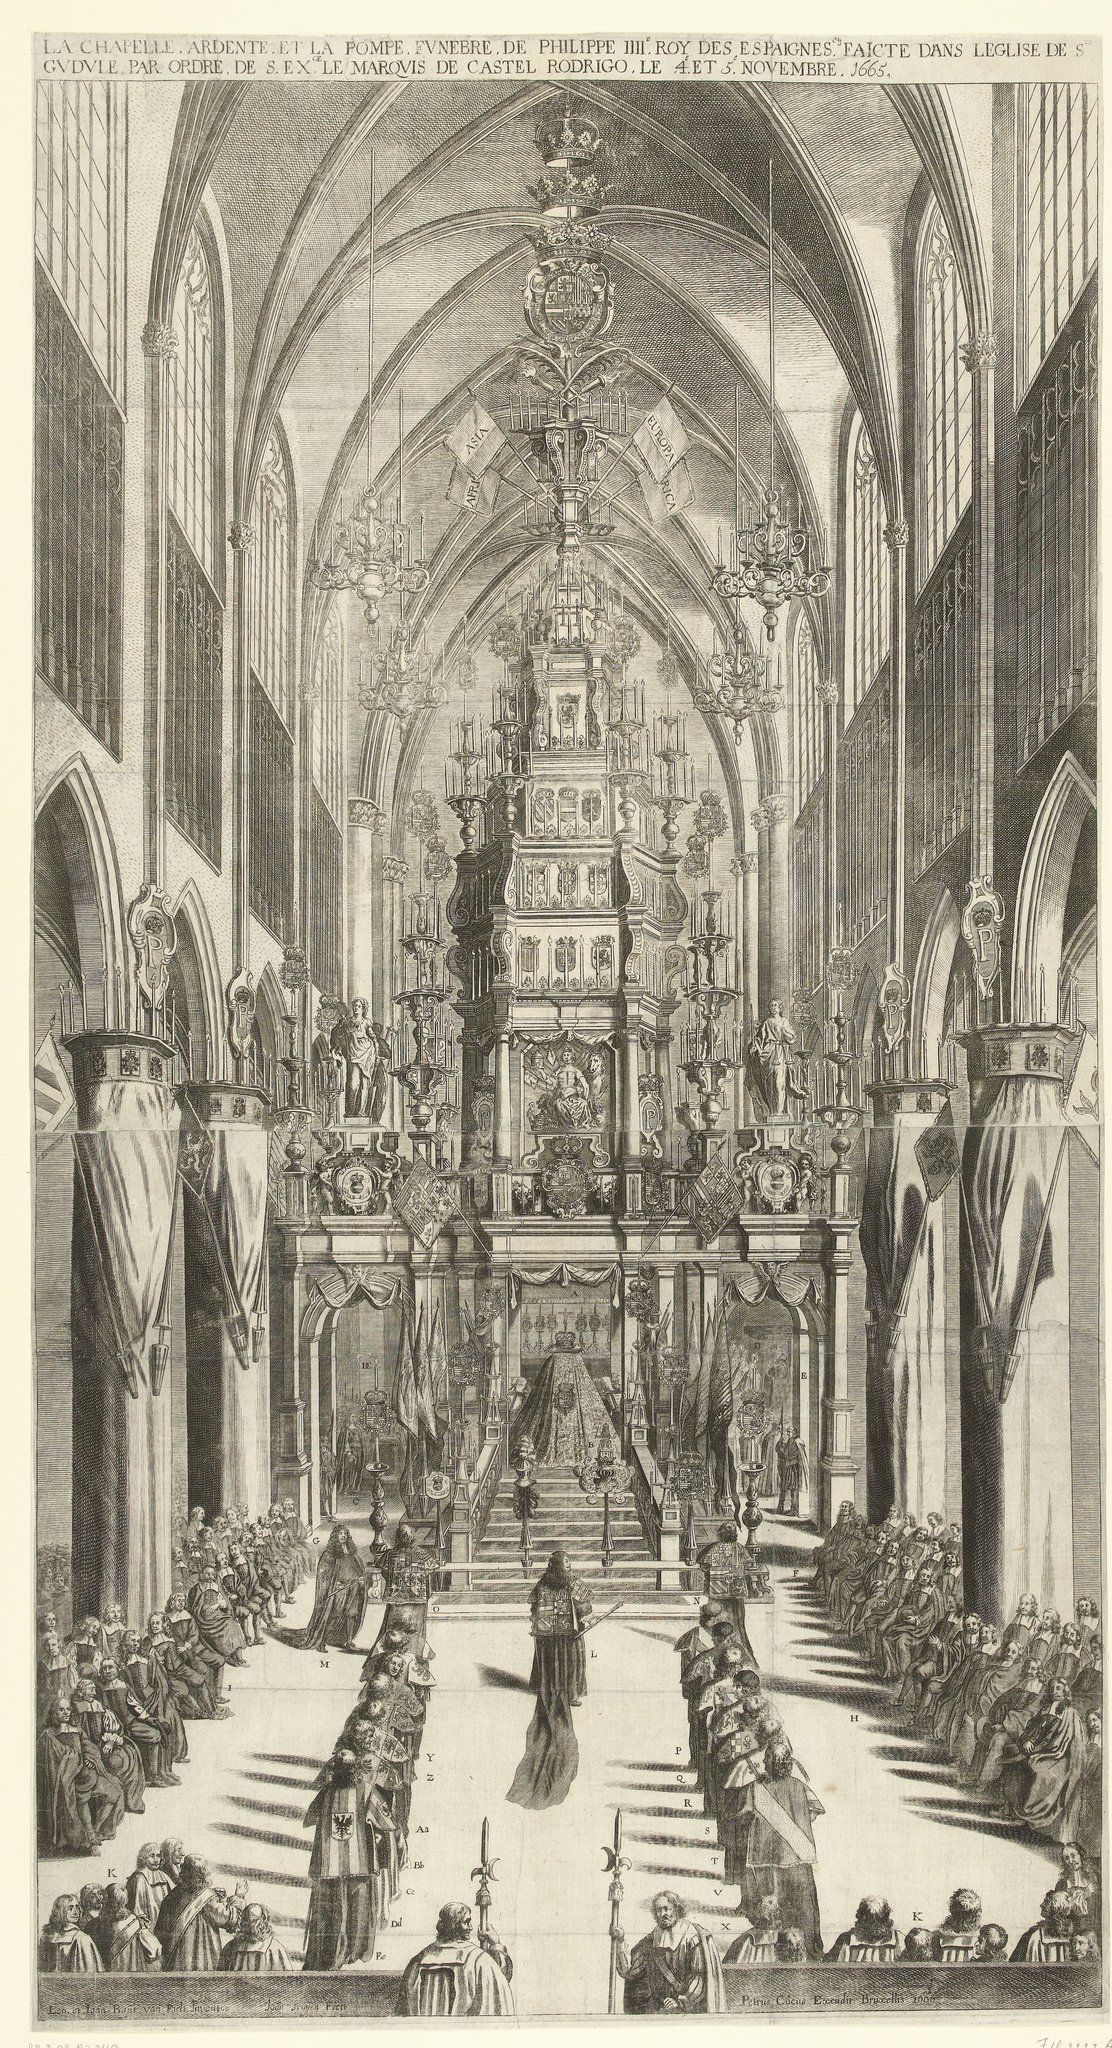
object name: print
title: Lijkdienst voor Filips IV te Brussel, 1665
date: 1666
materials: paper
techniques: engraving, etching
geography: southern netherlands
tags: filips iv (koning van spanje), interior of church, catafalque, 'castrum doloris' (~ public funeral), funerary ceremonial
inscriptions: date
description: Lijkdienst gehouden op 4 en 5 november 1665 voor de overleden Spaanse koning Filips IV in de Sint-Goedelekathedraal te Brussel. Gezicht in de kerk met de chapelle ardente, links en rechts zitten hoogwaardigheidsbekleders. Op de voorgrond een stoet van herauten met de verschillende kwartierwapens. Details in de voorstelling gemerkt met letters, maar de legenda ontbreekt. Grote voorstelling gedrukt van twee platen.